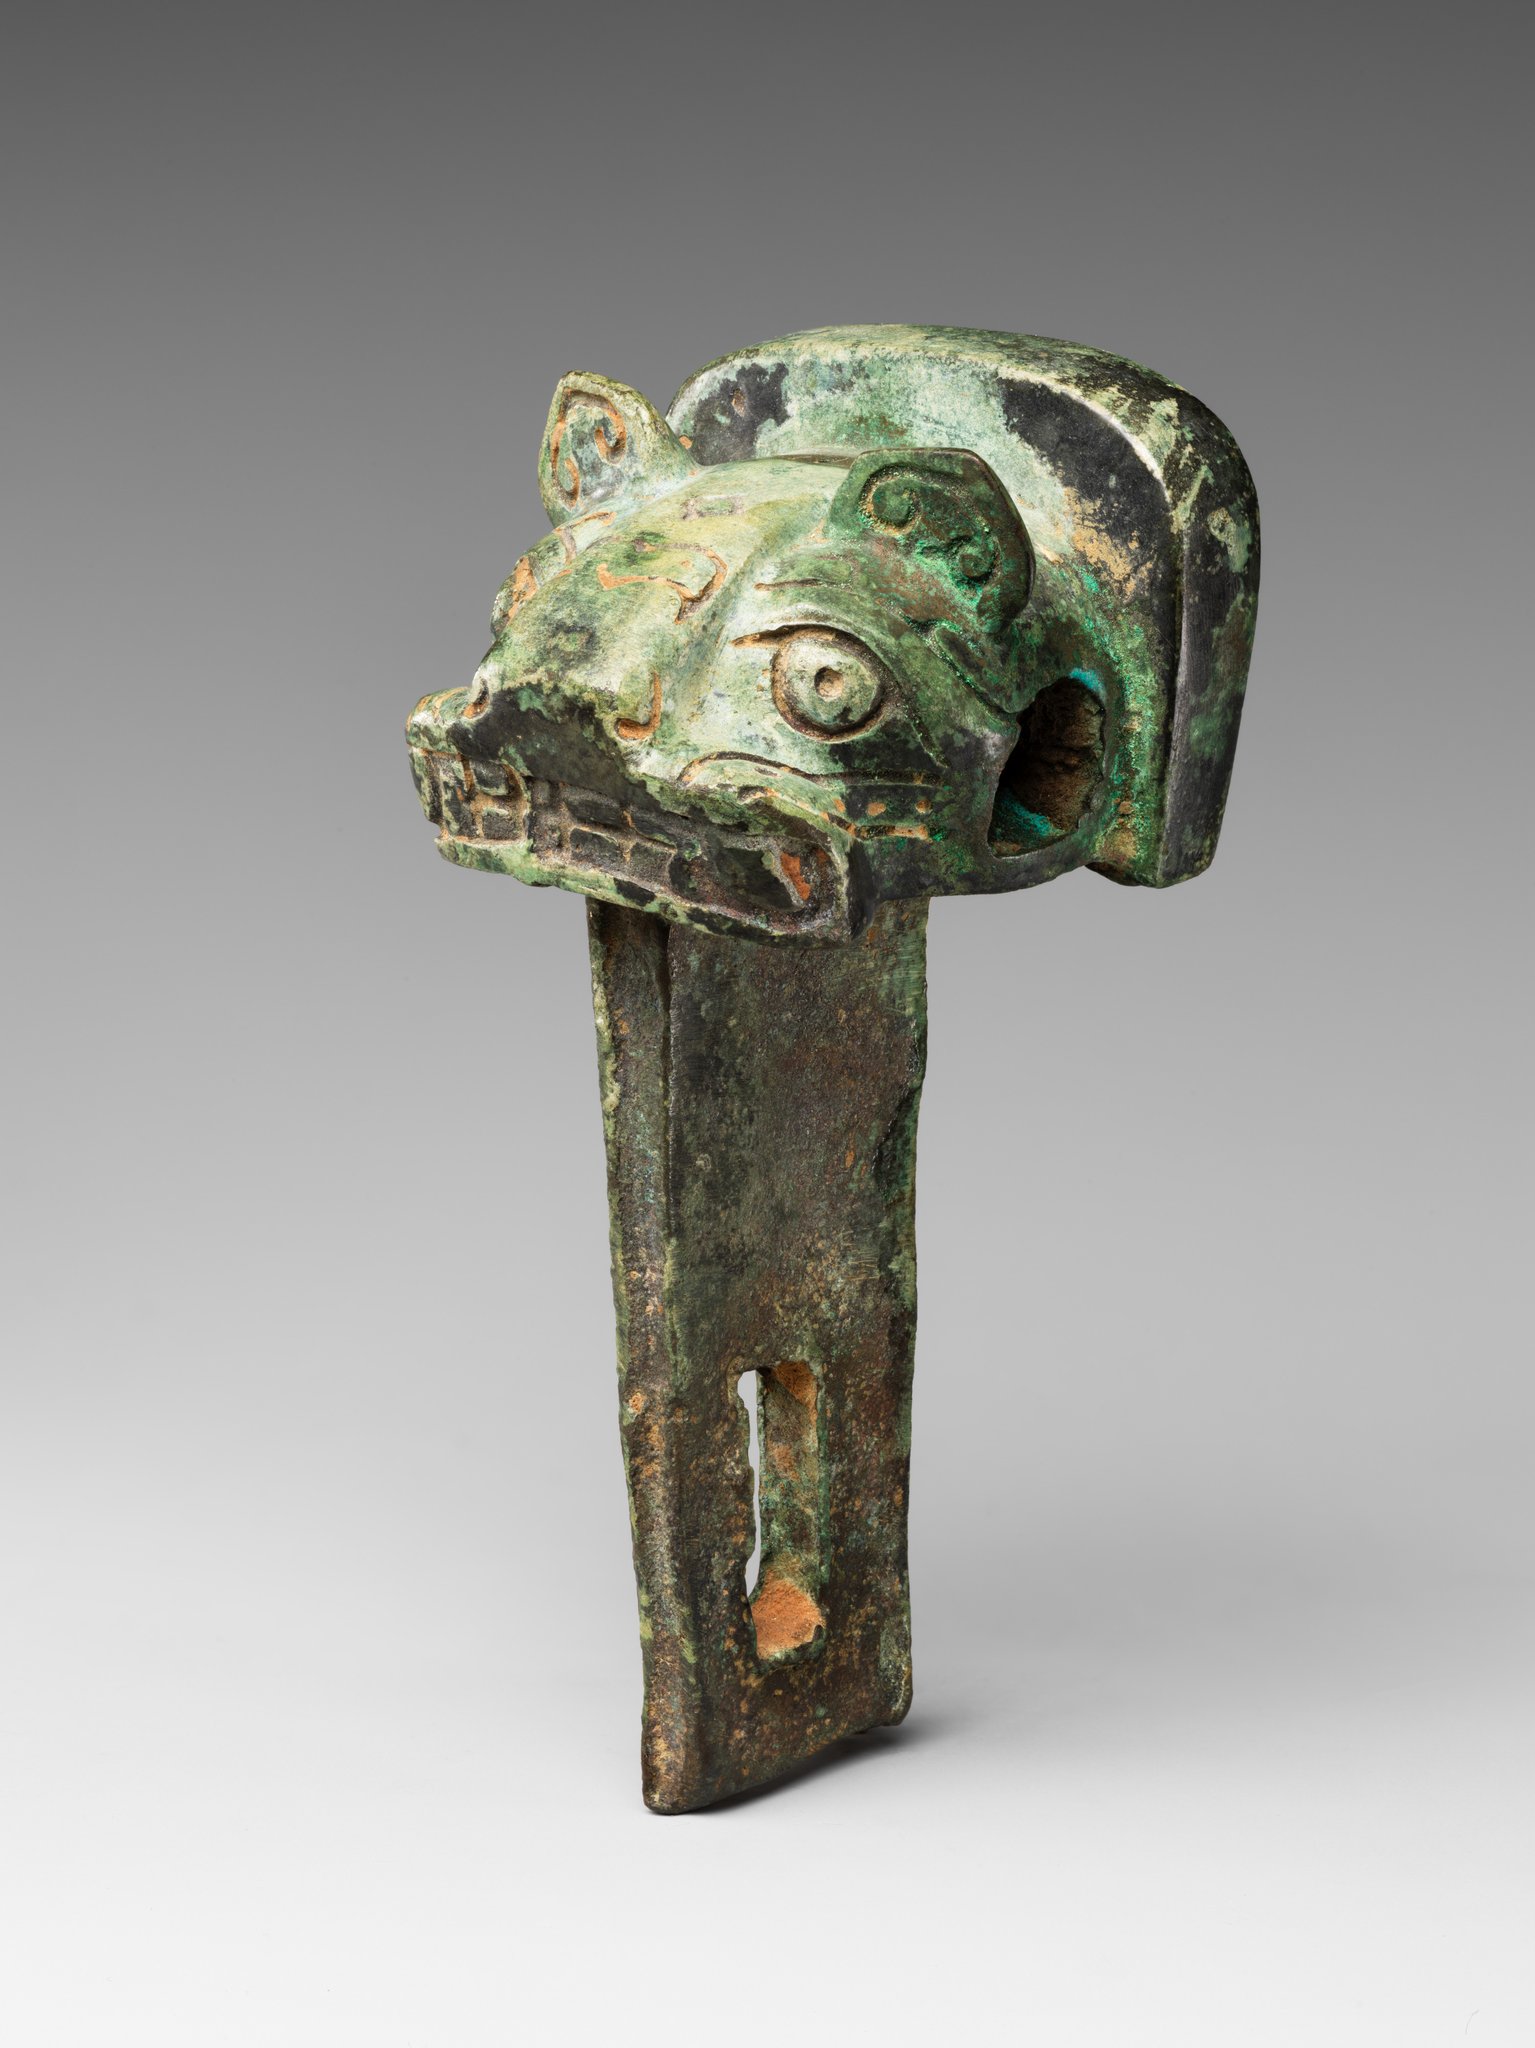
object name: chariot linchpin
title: Chariot linchpin with a tiger head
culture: chinese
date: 1100-901 BCE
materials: bronze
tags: tigers